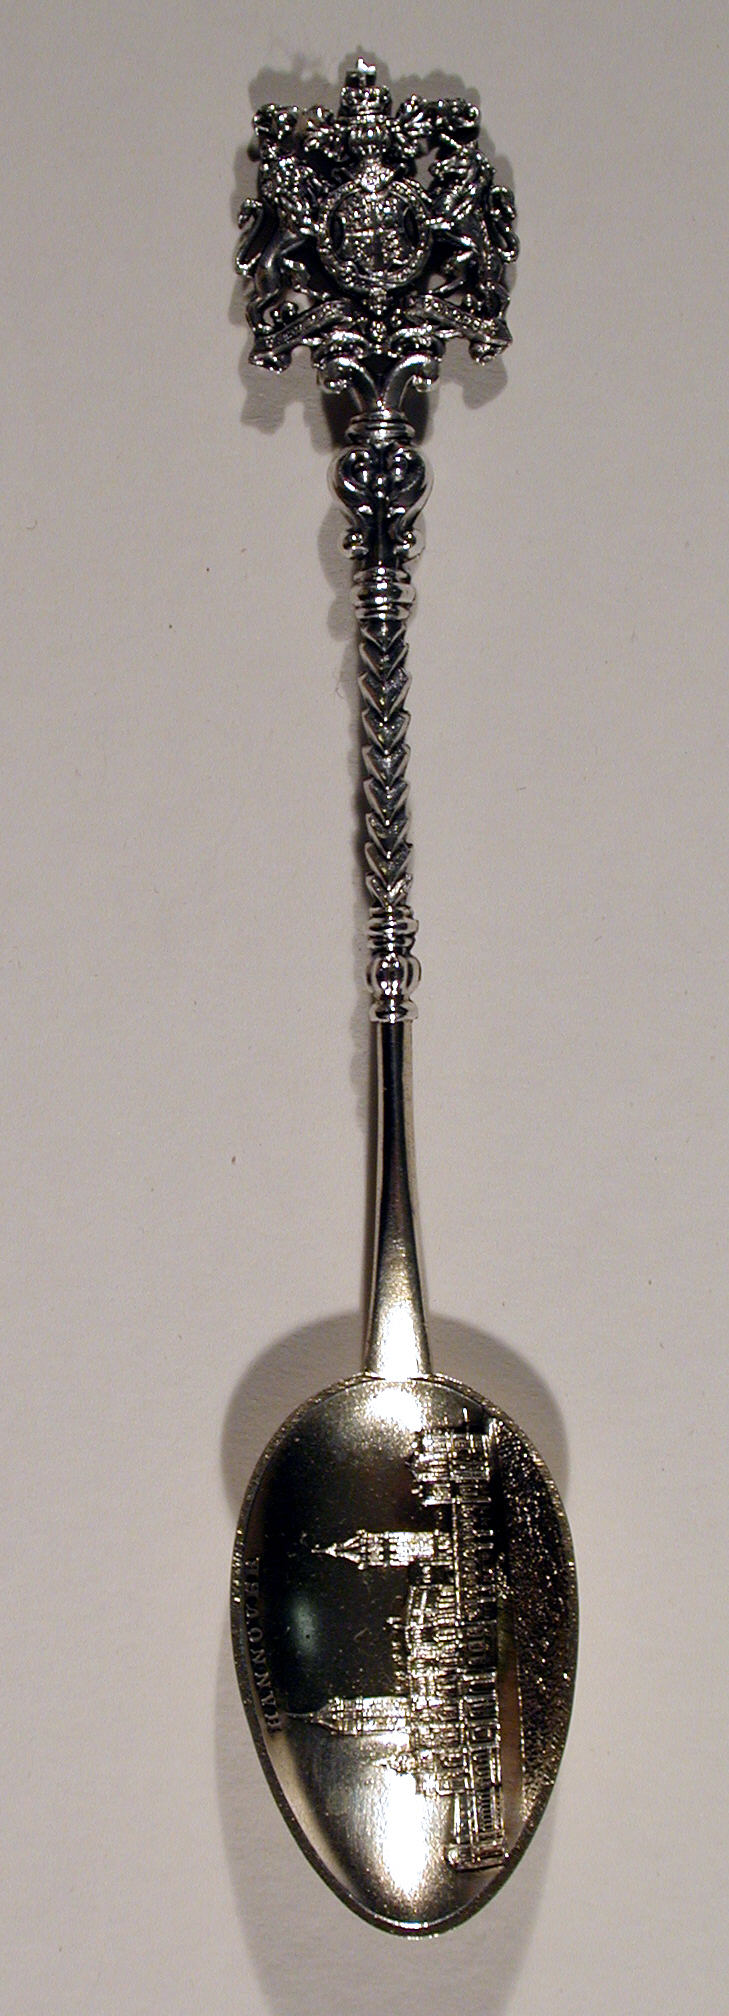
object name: souvenir spoon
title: Souvenir spoon with finial in form of arms of England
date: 1867-1900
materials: gilt, silver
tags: buildings,coat of arms